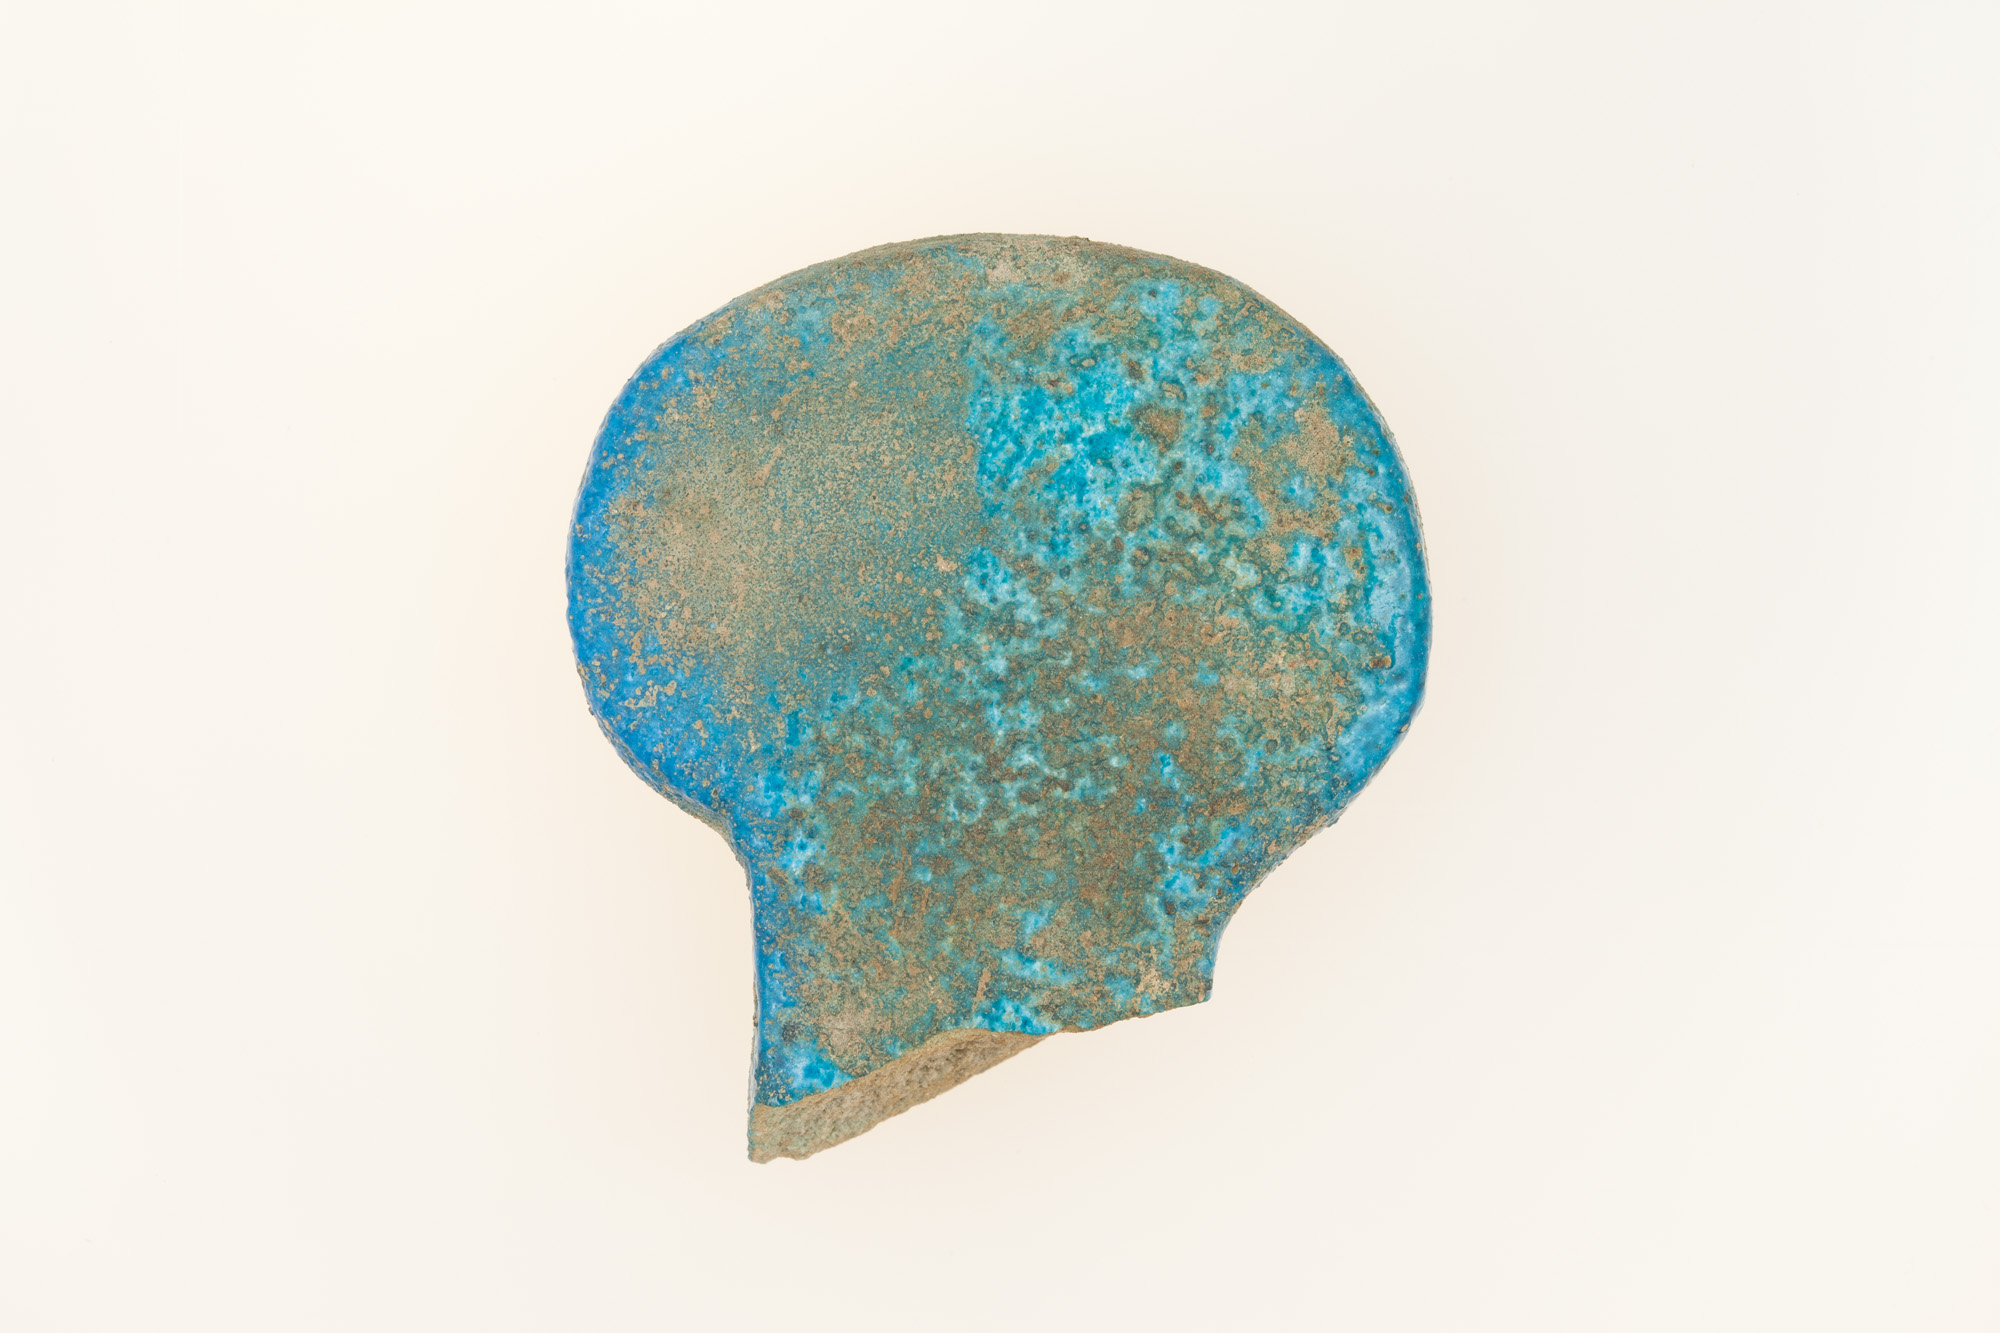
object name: menat fragment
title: Votive Menat fragments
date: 1479-1458 BCE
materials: faience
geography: egypt